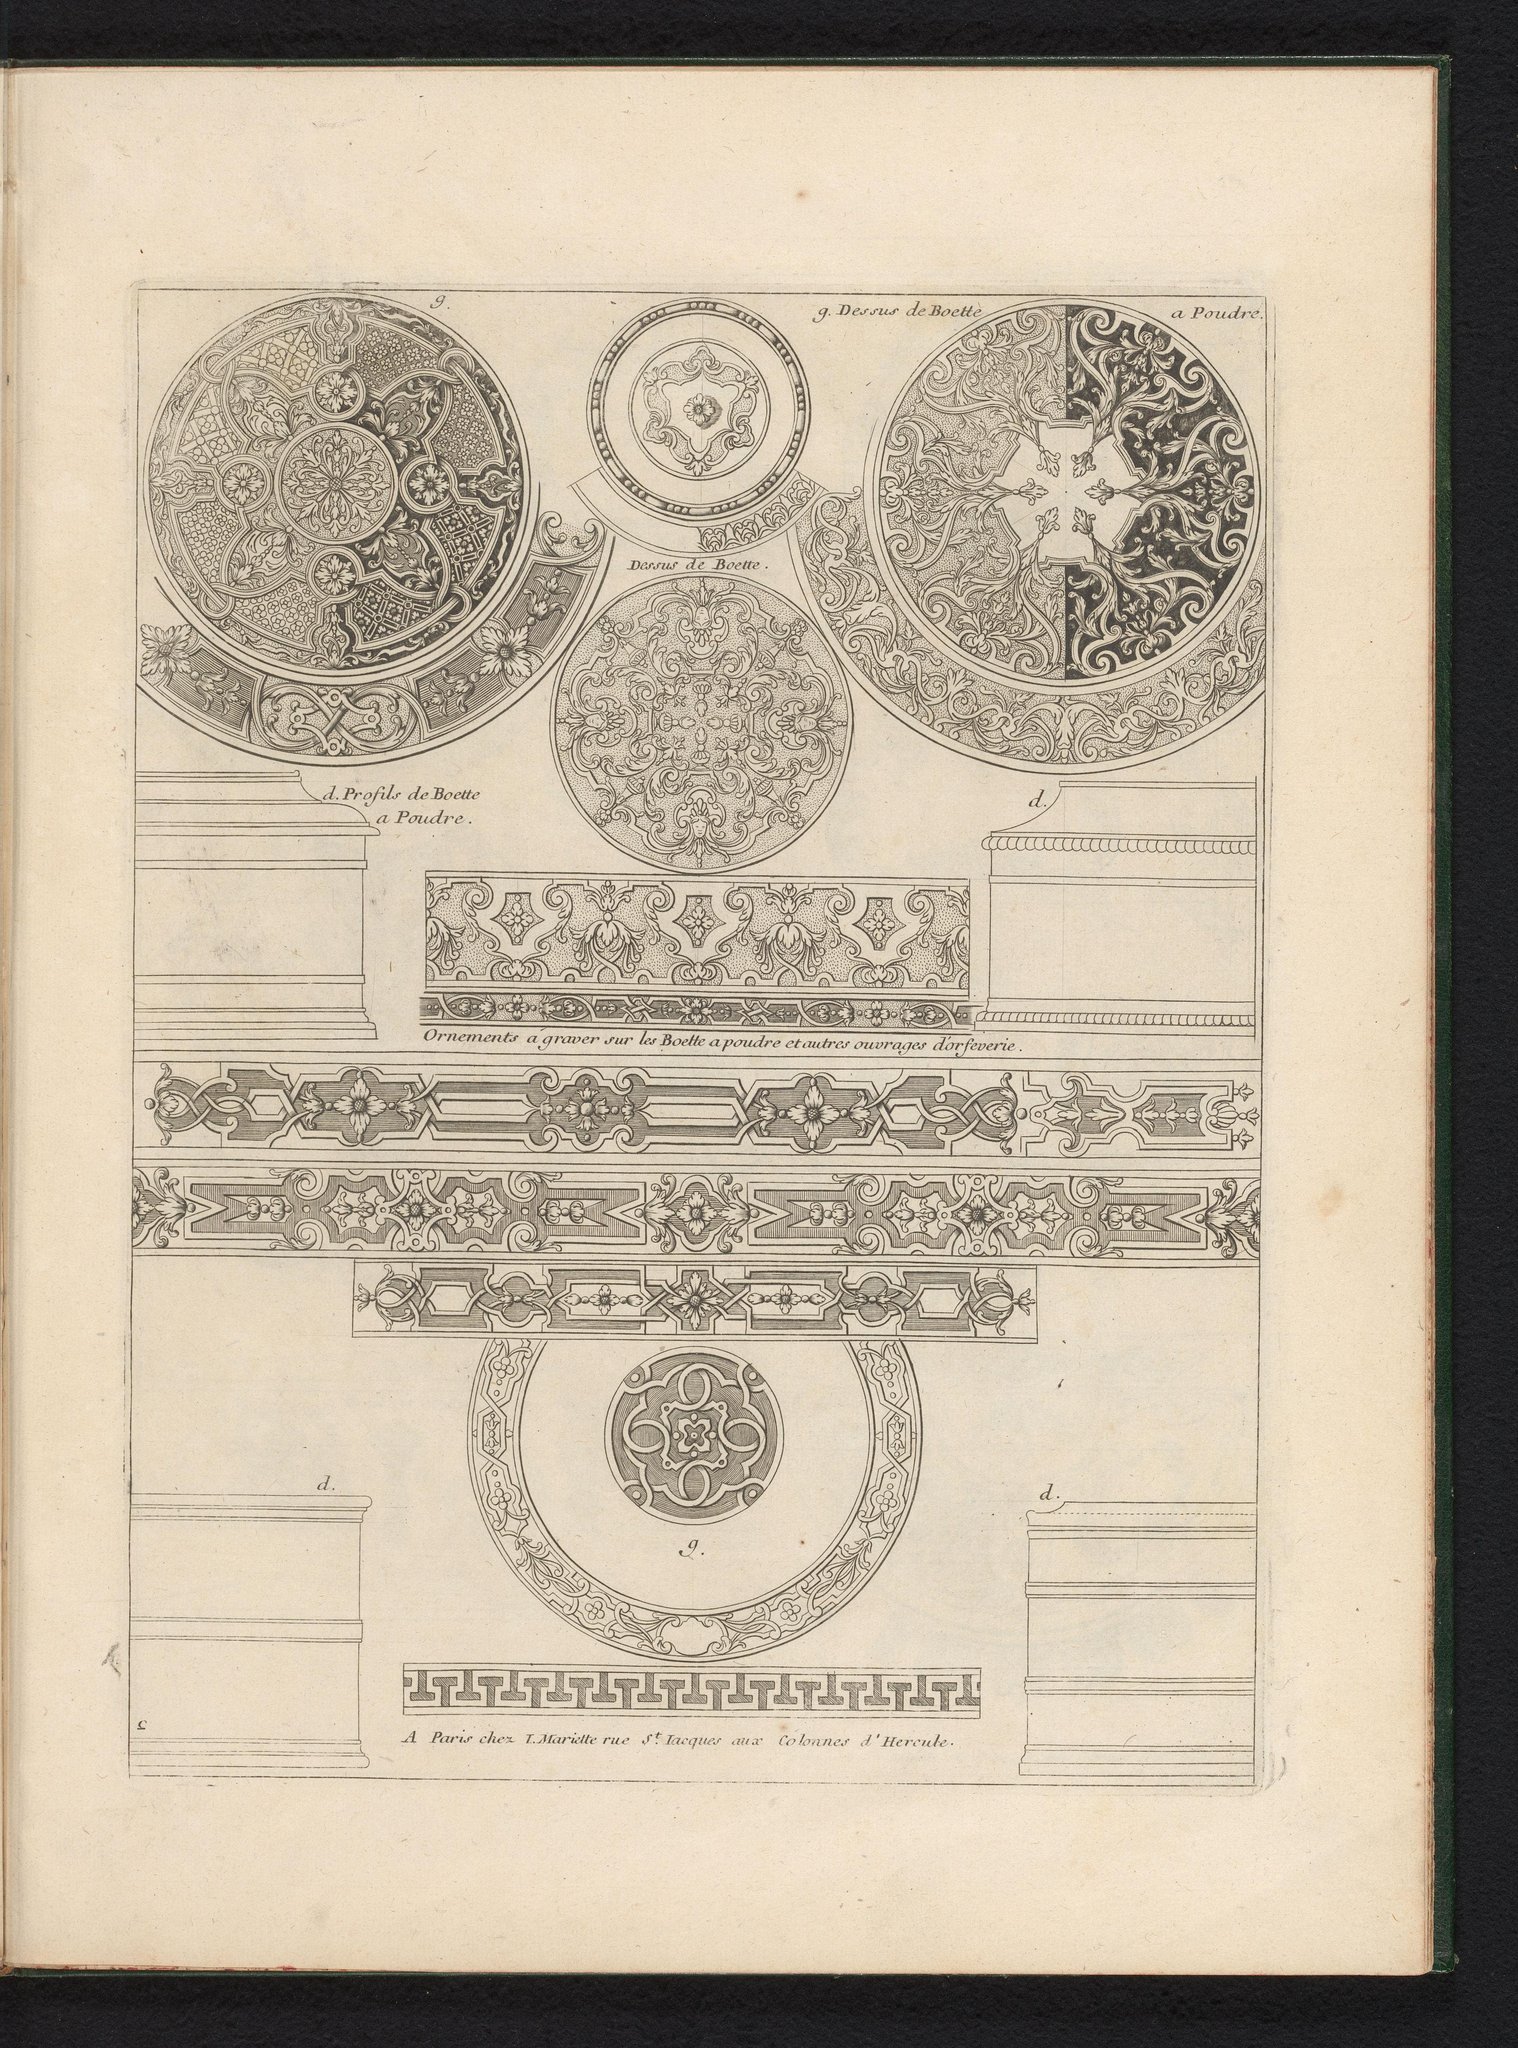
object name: album leaf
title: Ornements a graver sur le boette a poudre et autres ouvrages d'orfevrerie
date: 1700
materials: paper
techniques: engraving, etching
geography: paris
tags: jeweller, goldsmith, silversmith, ornamenting, decorating ~ applied arts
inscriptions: collector's mark: Lugt 2228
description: Profielen van poederdozen, ontwerpen voor decoratie van onderzijde en deksel, en decoratieve randen. Deze prent maakt deel uit van een album.